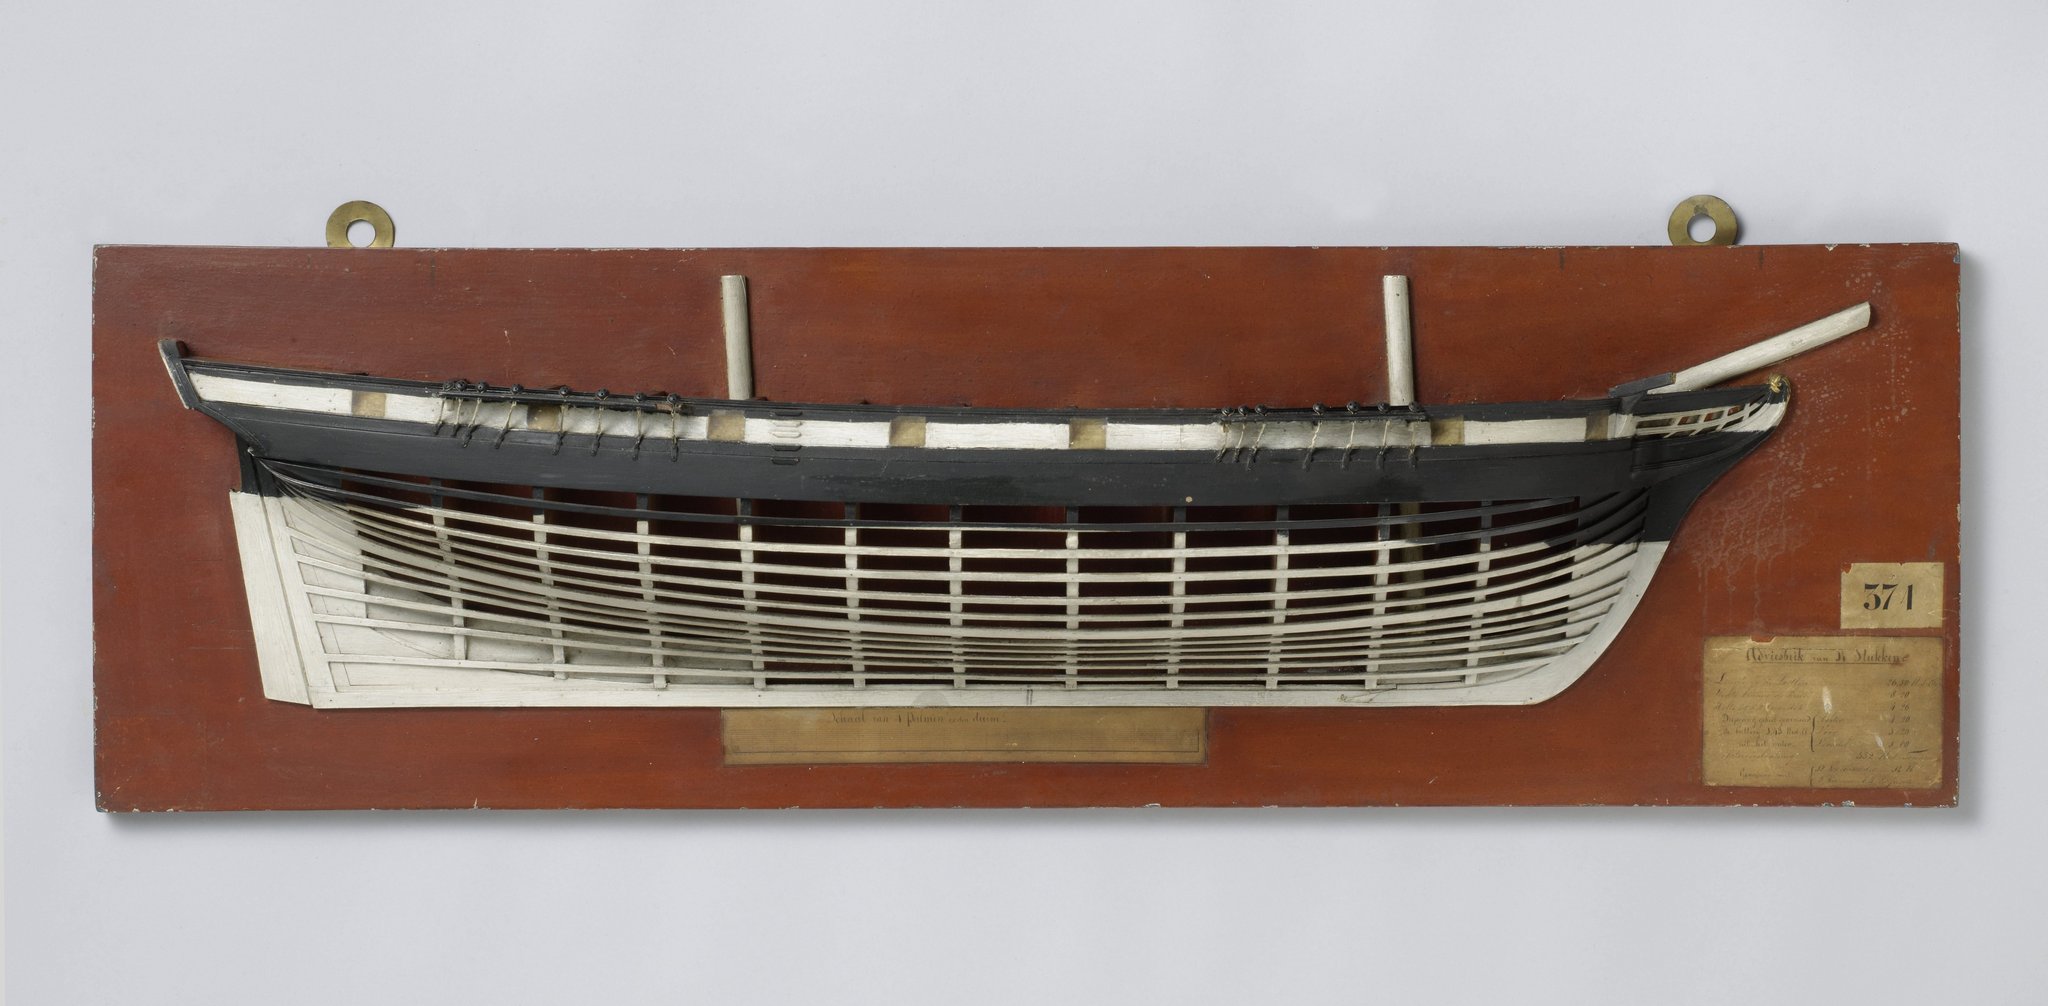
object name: ship model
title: Half Model of a 14-Gun Brig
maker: Anonymous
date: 1826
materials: metal, wood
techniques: polychromy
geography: rotterdam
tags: rotterdam, surabaya, hellevoetsluis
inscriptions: scale, bottom centre: paper scale in inches, label, centre right: ‘371’ former inventory label, inscription, bottom right, on a piece of paper, in ink: ‘Adviesbrik van 14 Stukken / [followed by measurements and armament]’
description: Gepolychromeerd mallenmodel (stuurboord) van een tweemaster. De huid boven het barkhout is gesloten, zeven geschilderde geschutpoorten op één dek. Voorschip uitgewerkt met galjoen en schegbeeld van een vergulde krul. Gewrongen spiegel, hol wulf, hek met drie lichten, geen zijgalerij; recht roer met vierkante roerkoning. Zeeg naar voor en achter iets oplopend, één barkhout en één reehout. Gepiekt rondspant. Schaal 1:40 (schaal op model).